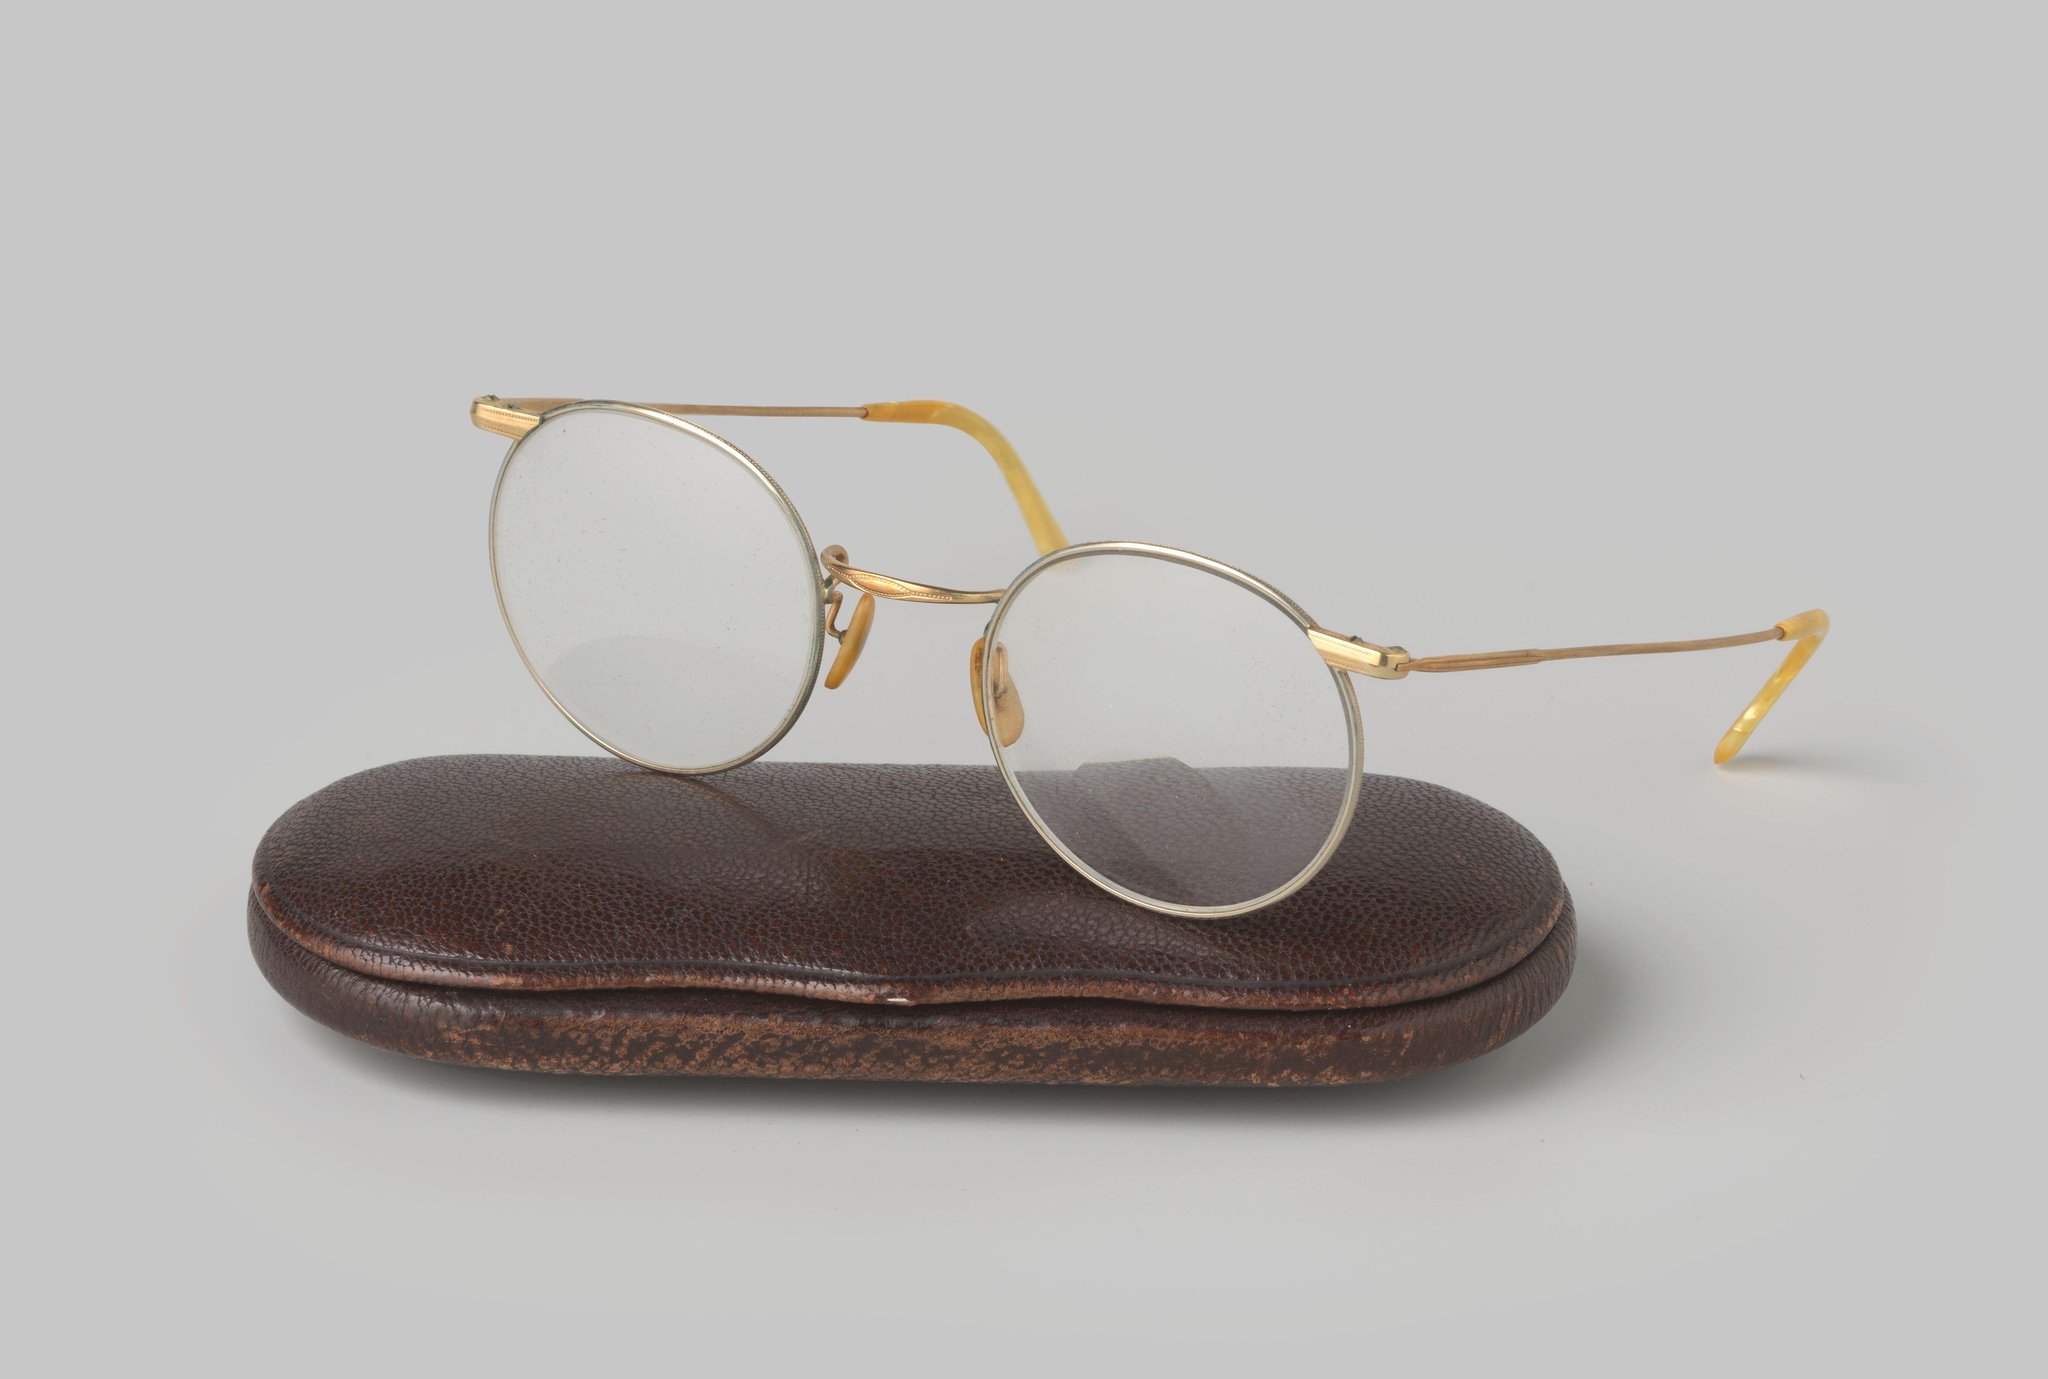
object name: brillenkoker, brillenetui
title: Bril met brillenetui van leer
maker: Anonymous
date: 1900-1925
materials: glass, leather, metal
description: Dit object is onderdeel van de nalatenschap van Isabel Elon-Wachenheimer (1928-2010). Tot haar overlijden behoorde het samen met de andere objecten uit de nalatenschap tot haar privédomein van Isabel Wachenheimer. In die particuliere context zijn deze objecten tezamen en individueel aandenkens - aan de jeugd, ouders en familie van Isabel Wachenheimer vóór en tijdens de Shoah en aan haar leven na de Tweede Wereldoorlog. Isabel Wachenheimer, die van juni 1943 tot mei 1945 gevangen zat in Kamp Westerbork, Theresienstadt, Auschwitz, Lenzing a/d Oberdonau (een buitenkamp van Mauthausen), overleefde de Shoah. Haar ouders – Eugène Wachenheimer en Else Wachenheimer-Moos - werden op 14 oktober 1944 in Auschwitz-Birkenau vermoord.